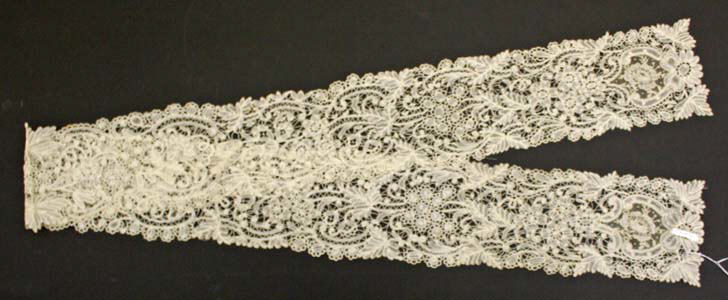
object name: scarf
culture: belgian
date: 1867-1900